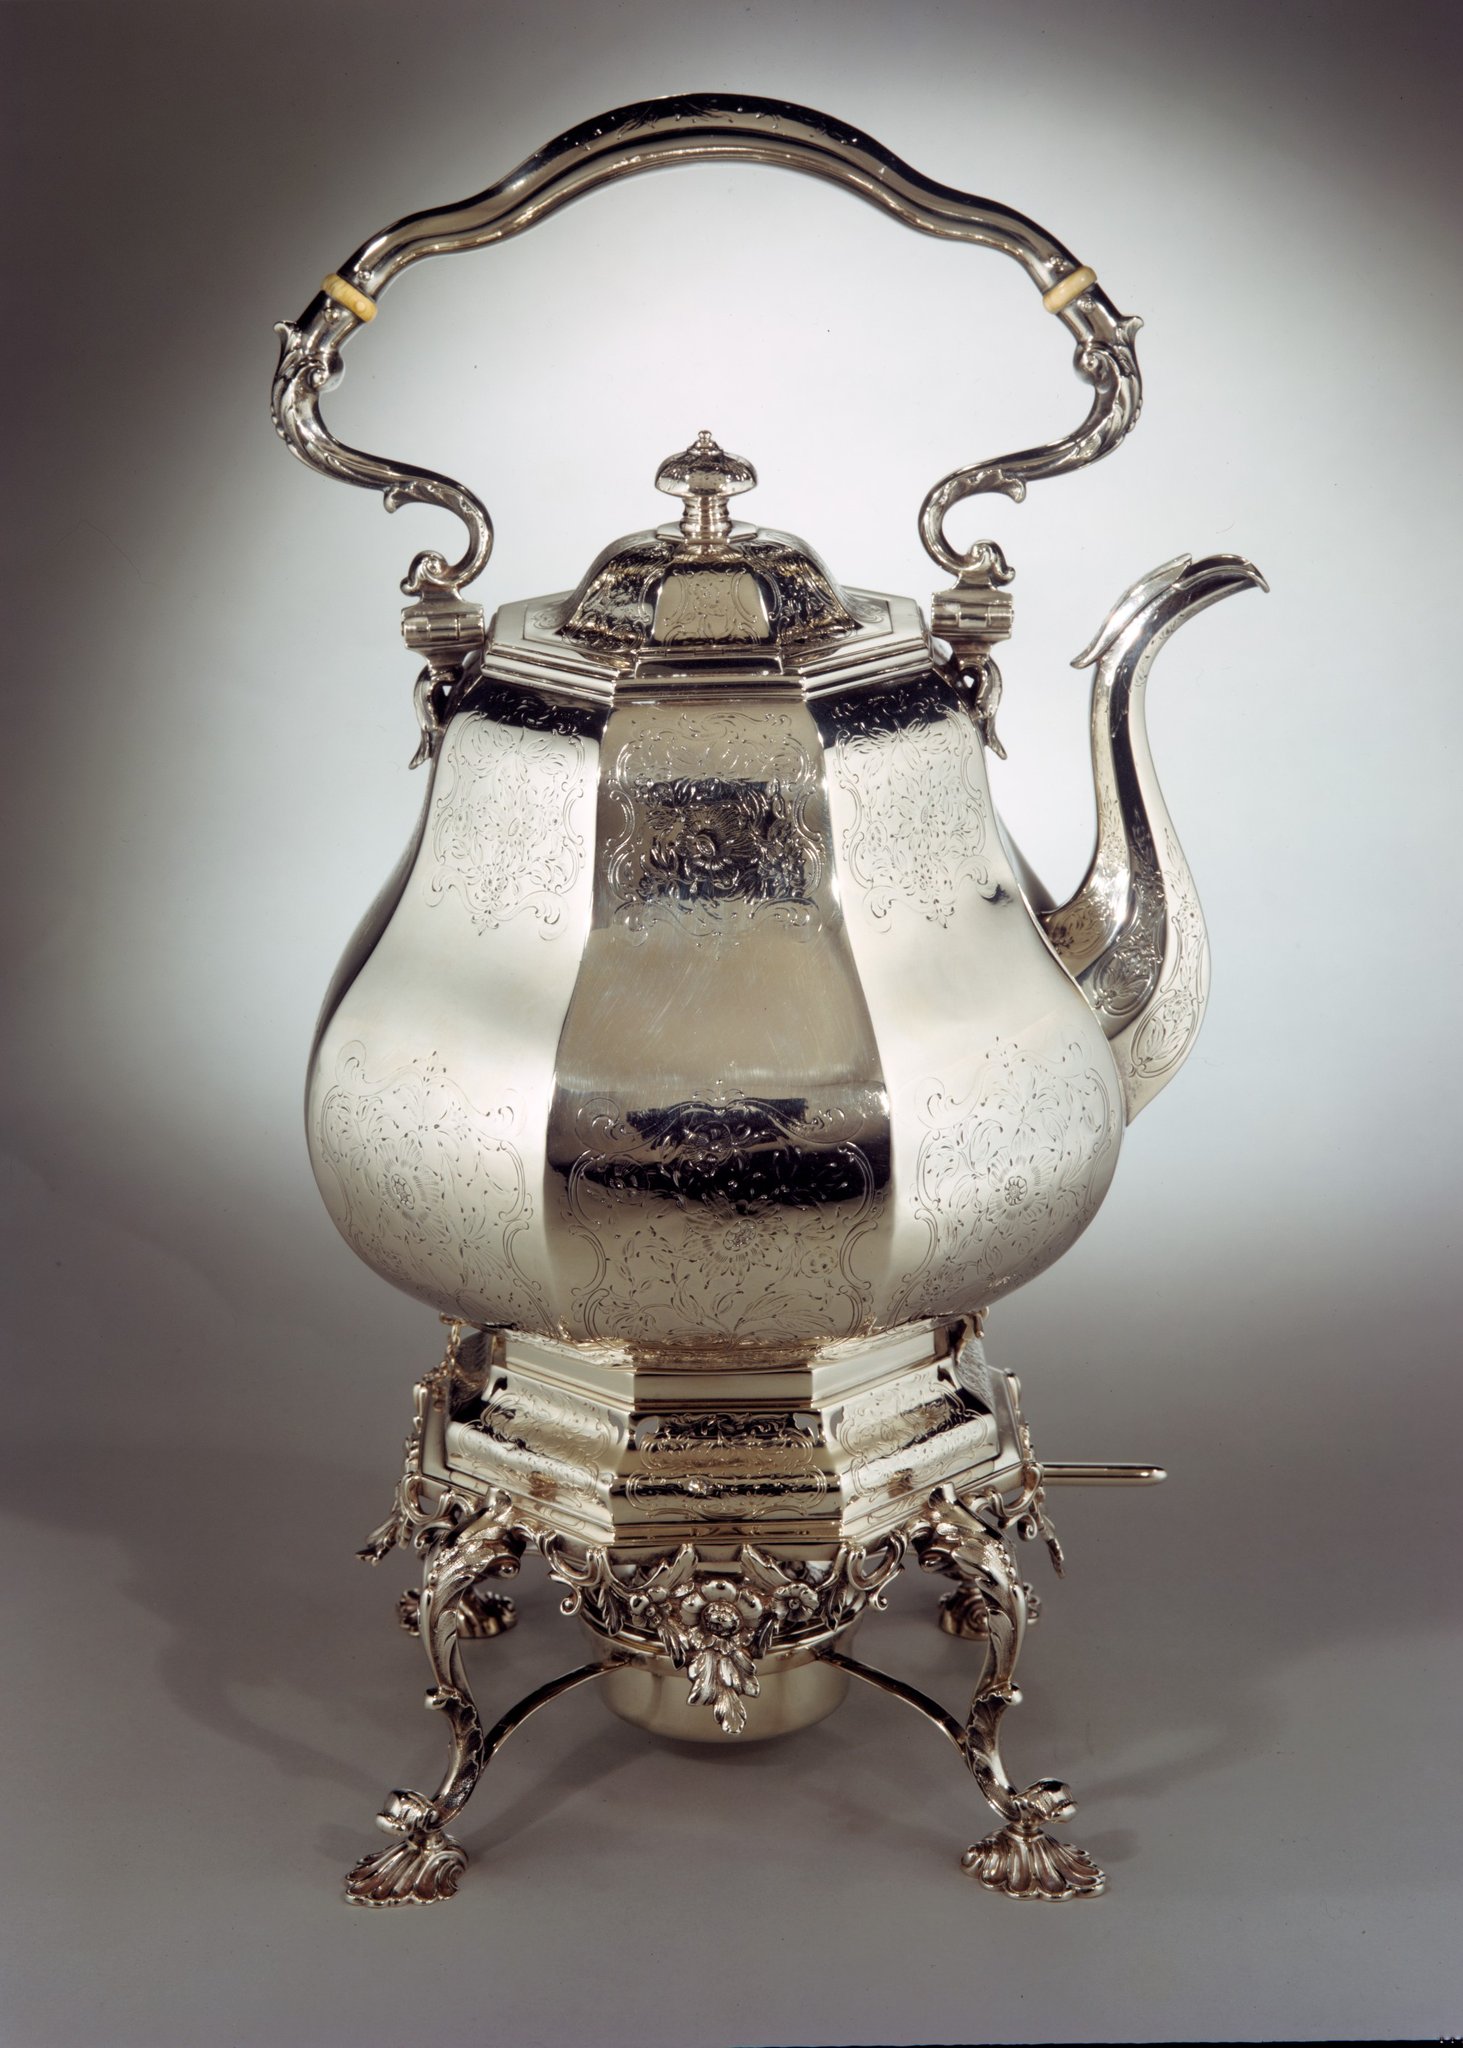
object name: teakettle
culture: american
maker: william forbes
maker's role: maker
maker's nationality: american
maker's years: 1826-1863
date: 1840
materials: ivory, silver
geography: united states